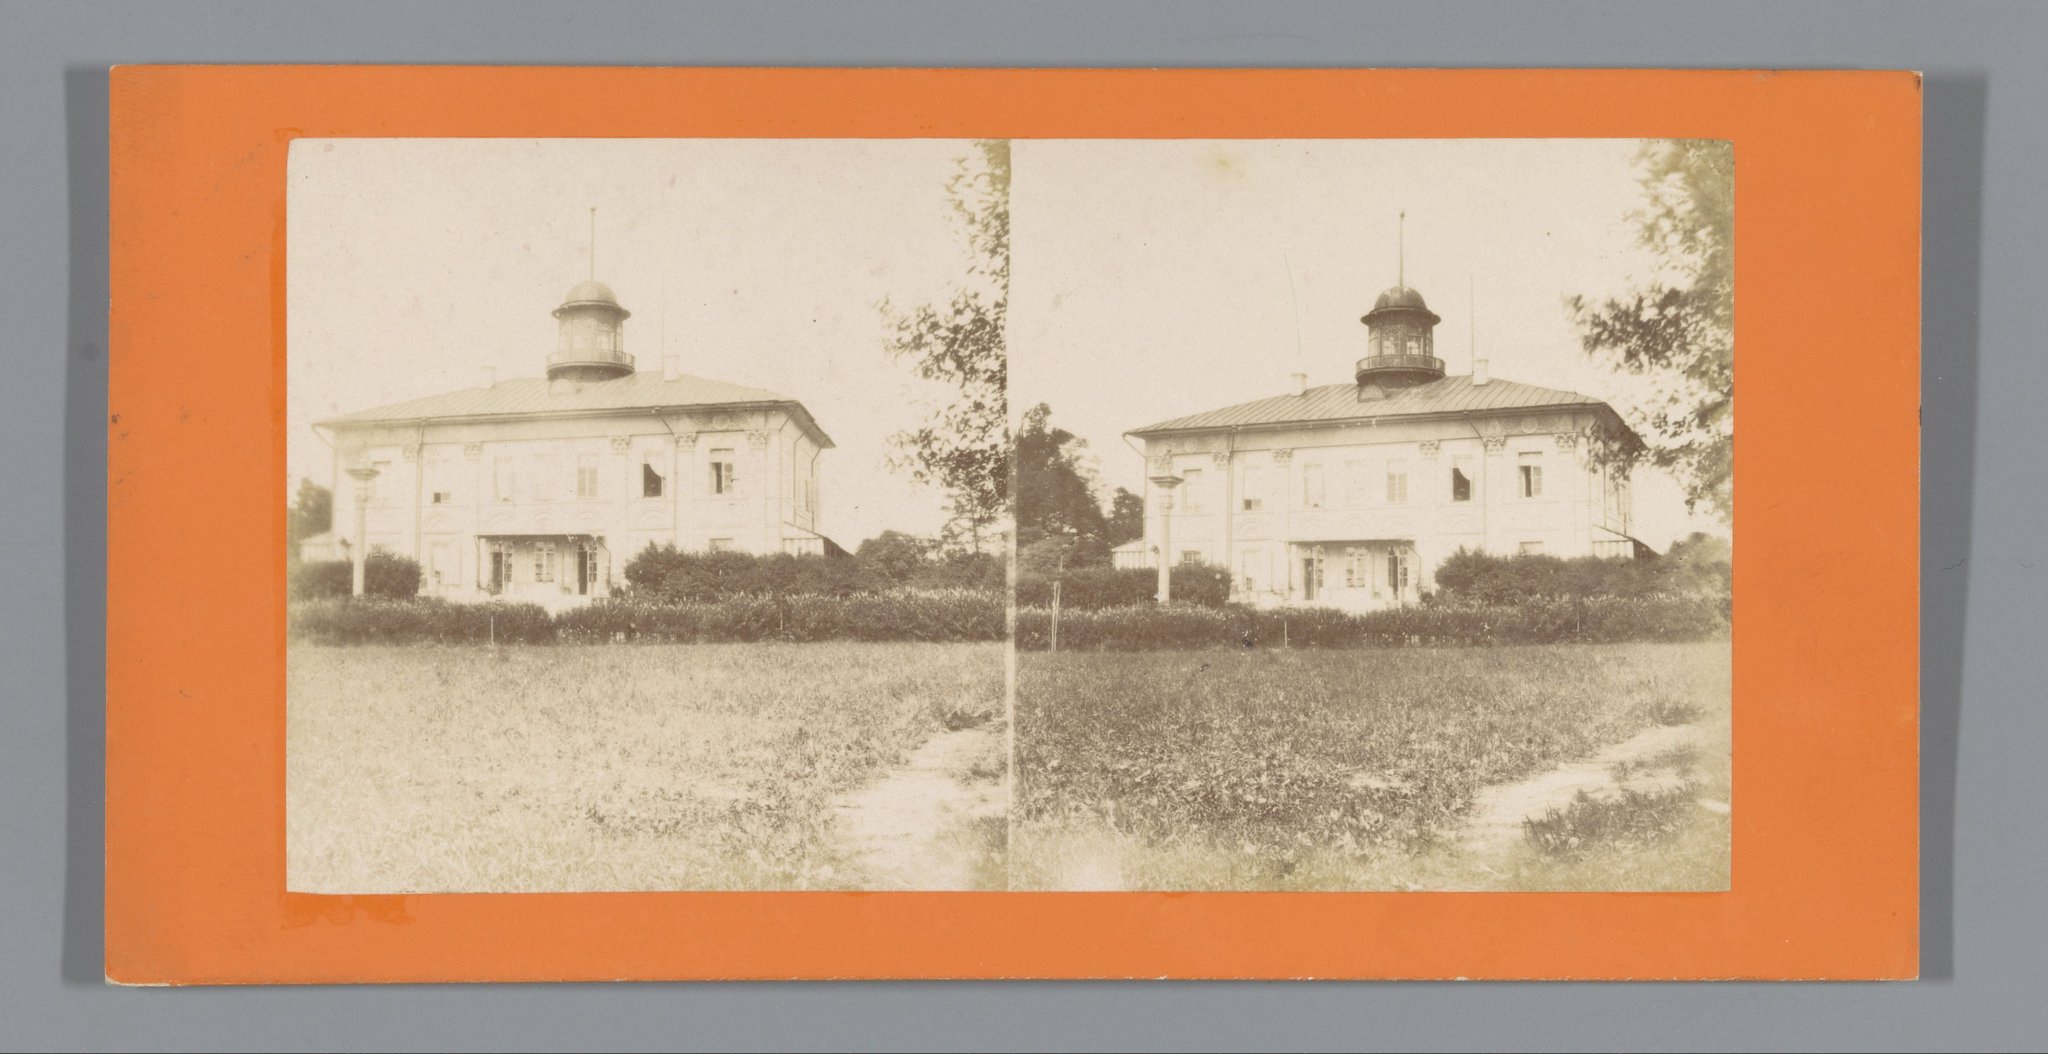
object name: stereograph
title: Gezicht op een huis in Moskou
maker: Anonymous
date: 1850-1880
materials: cardboard, photographic support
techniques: albumen print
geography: moscow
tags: rural housing, e.g. country-house, villa, cottage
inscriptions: inscription: ‘99 Maison Pagkoff Moscou’